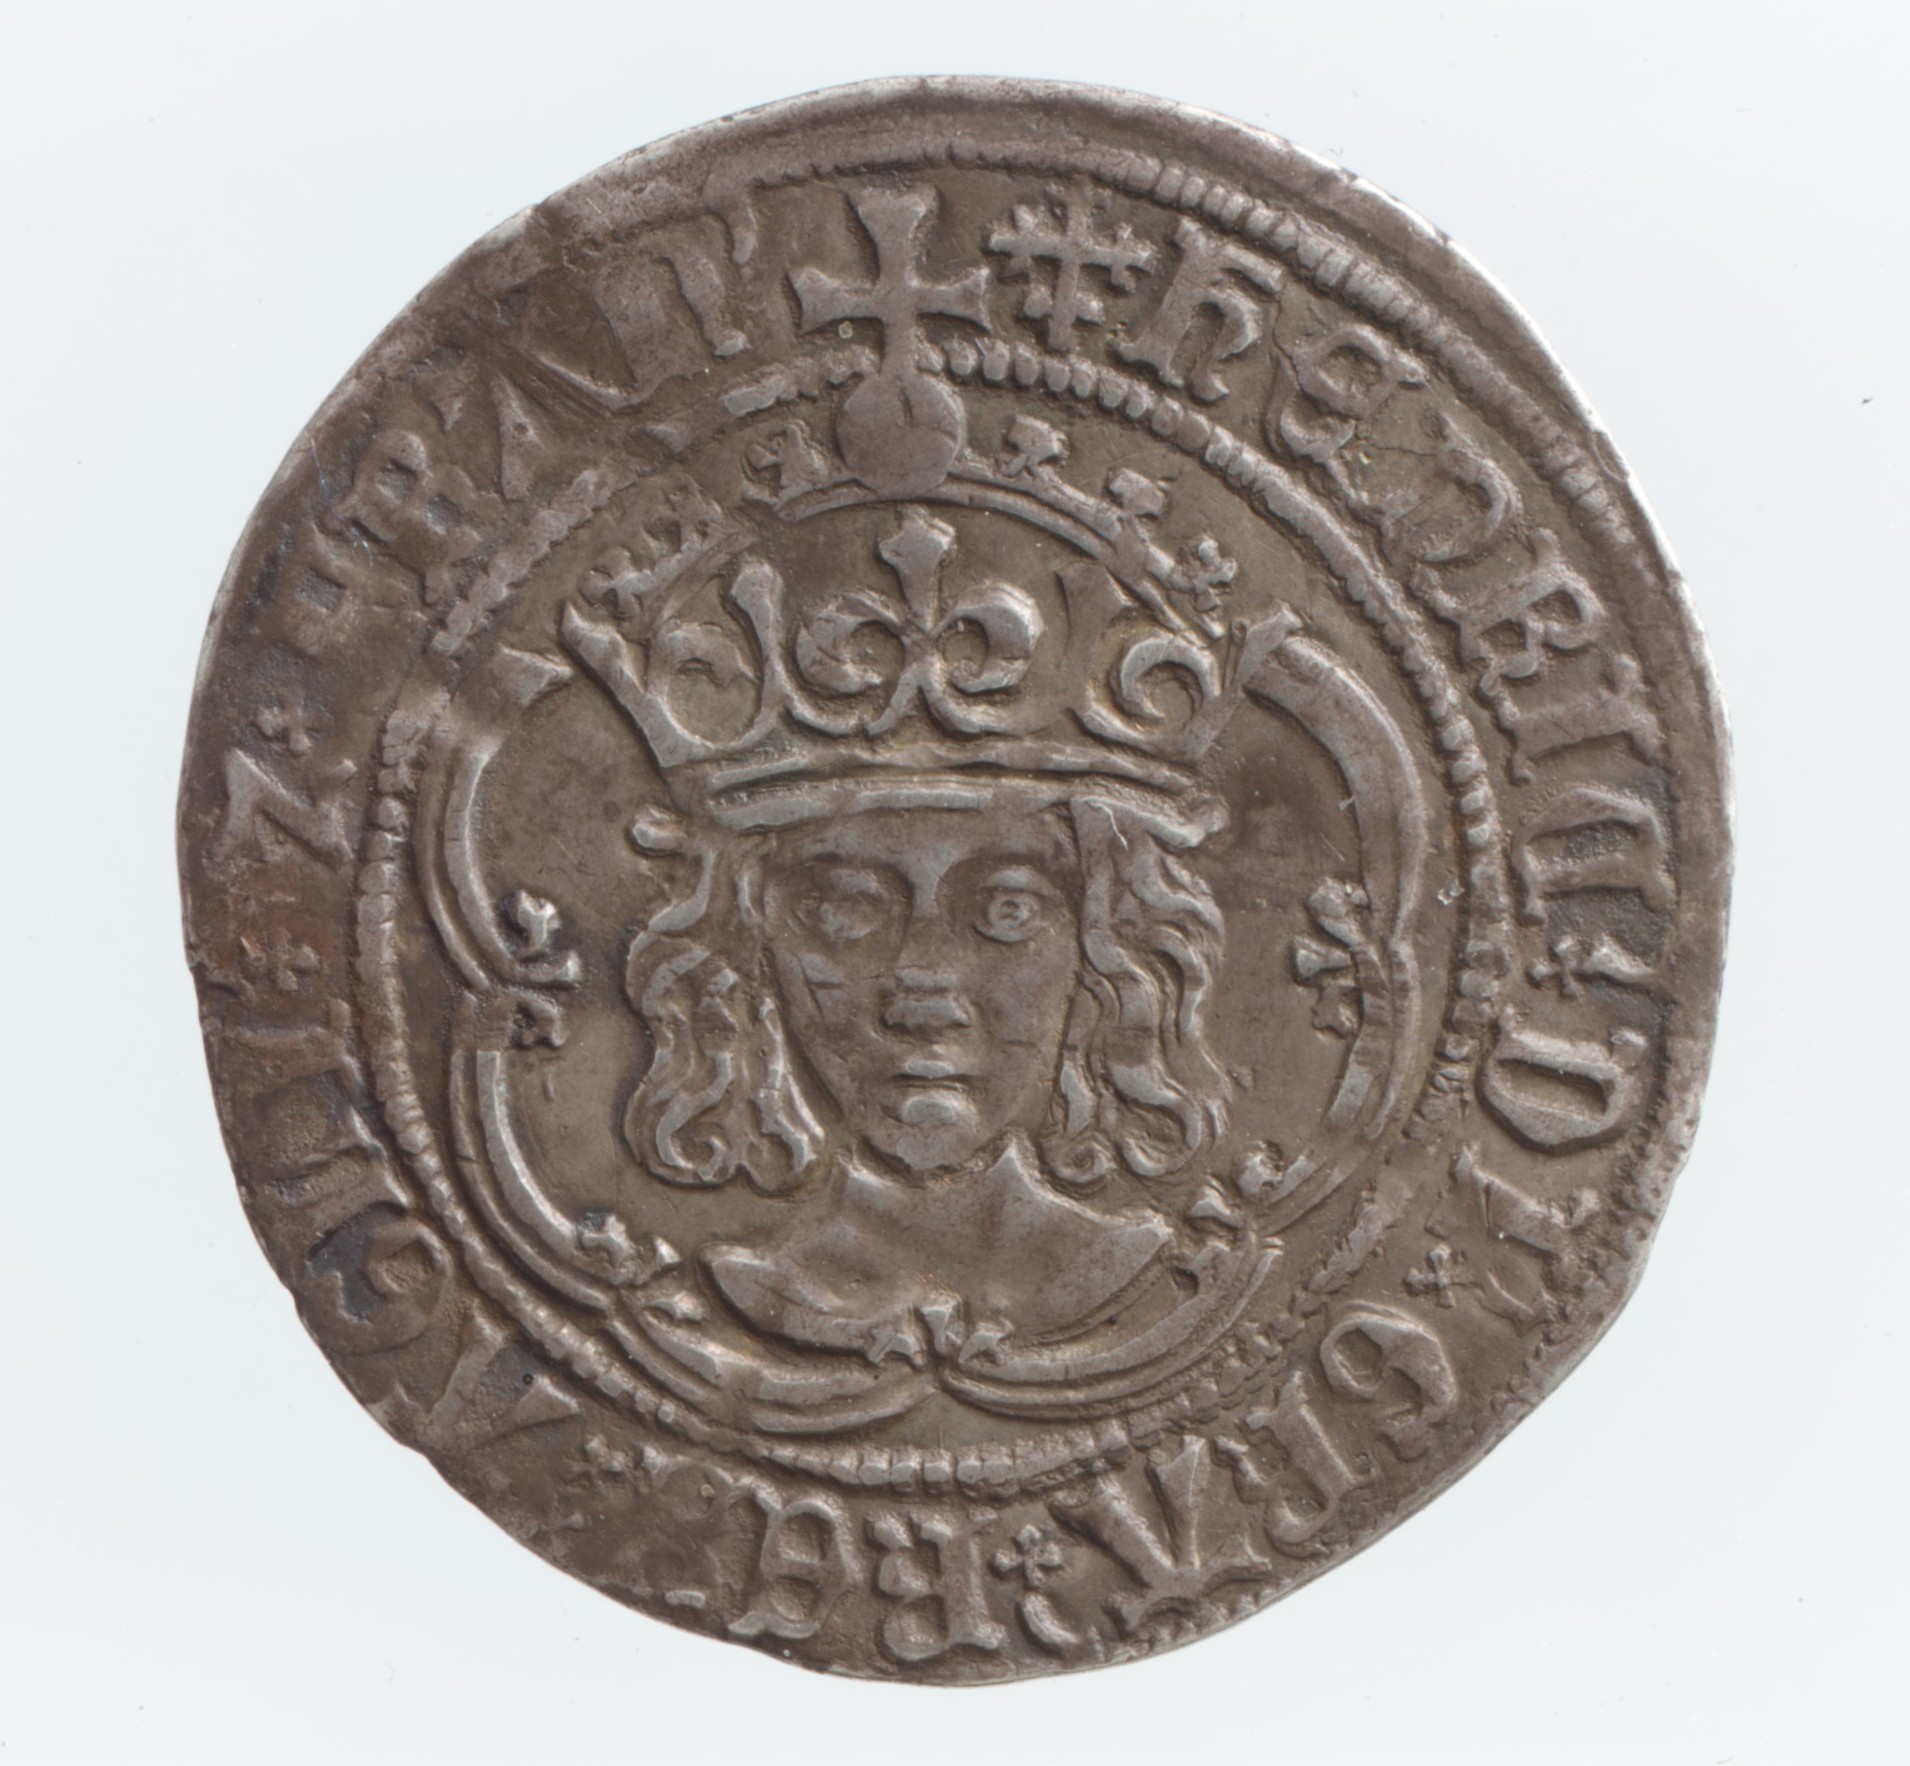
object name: groat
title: Groat of Henry VII (1485–1509)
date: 1501-1533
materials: silver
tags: men,portraits,coins